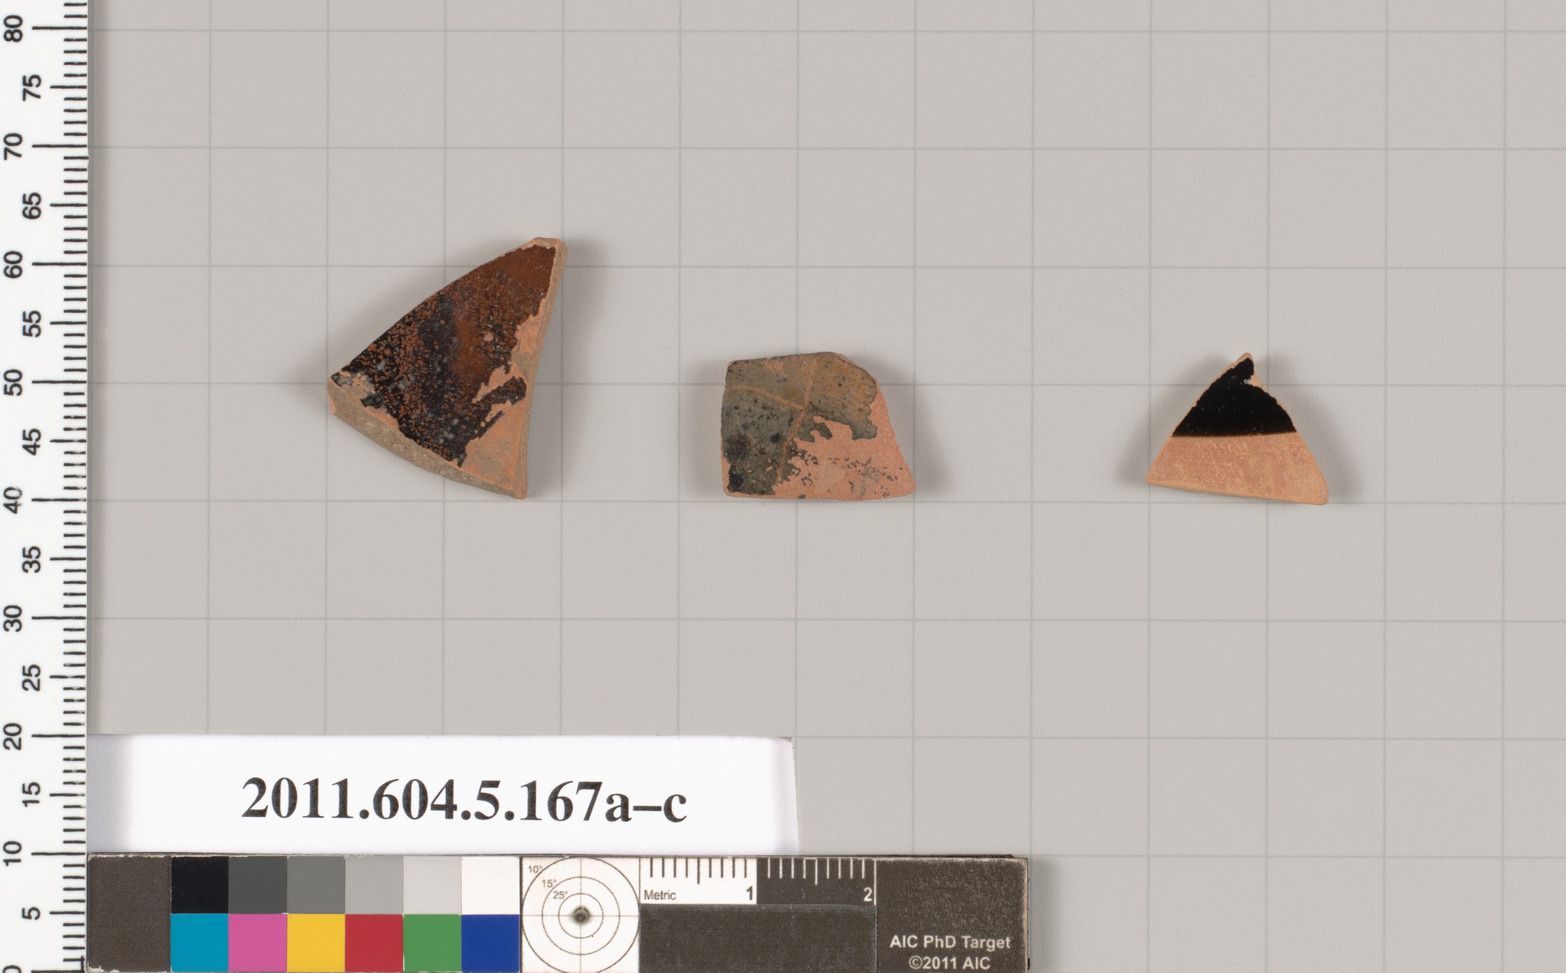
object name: kylix fragment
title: Terracotta fragments of kylikes (drinking cups)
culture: greek, attic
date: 600-401 BCE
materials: terracotta